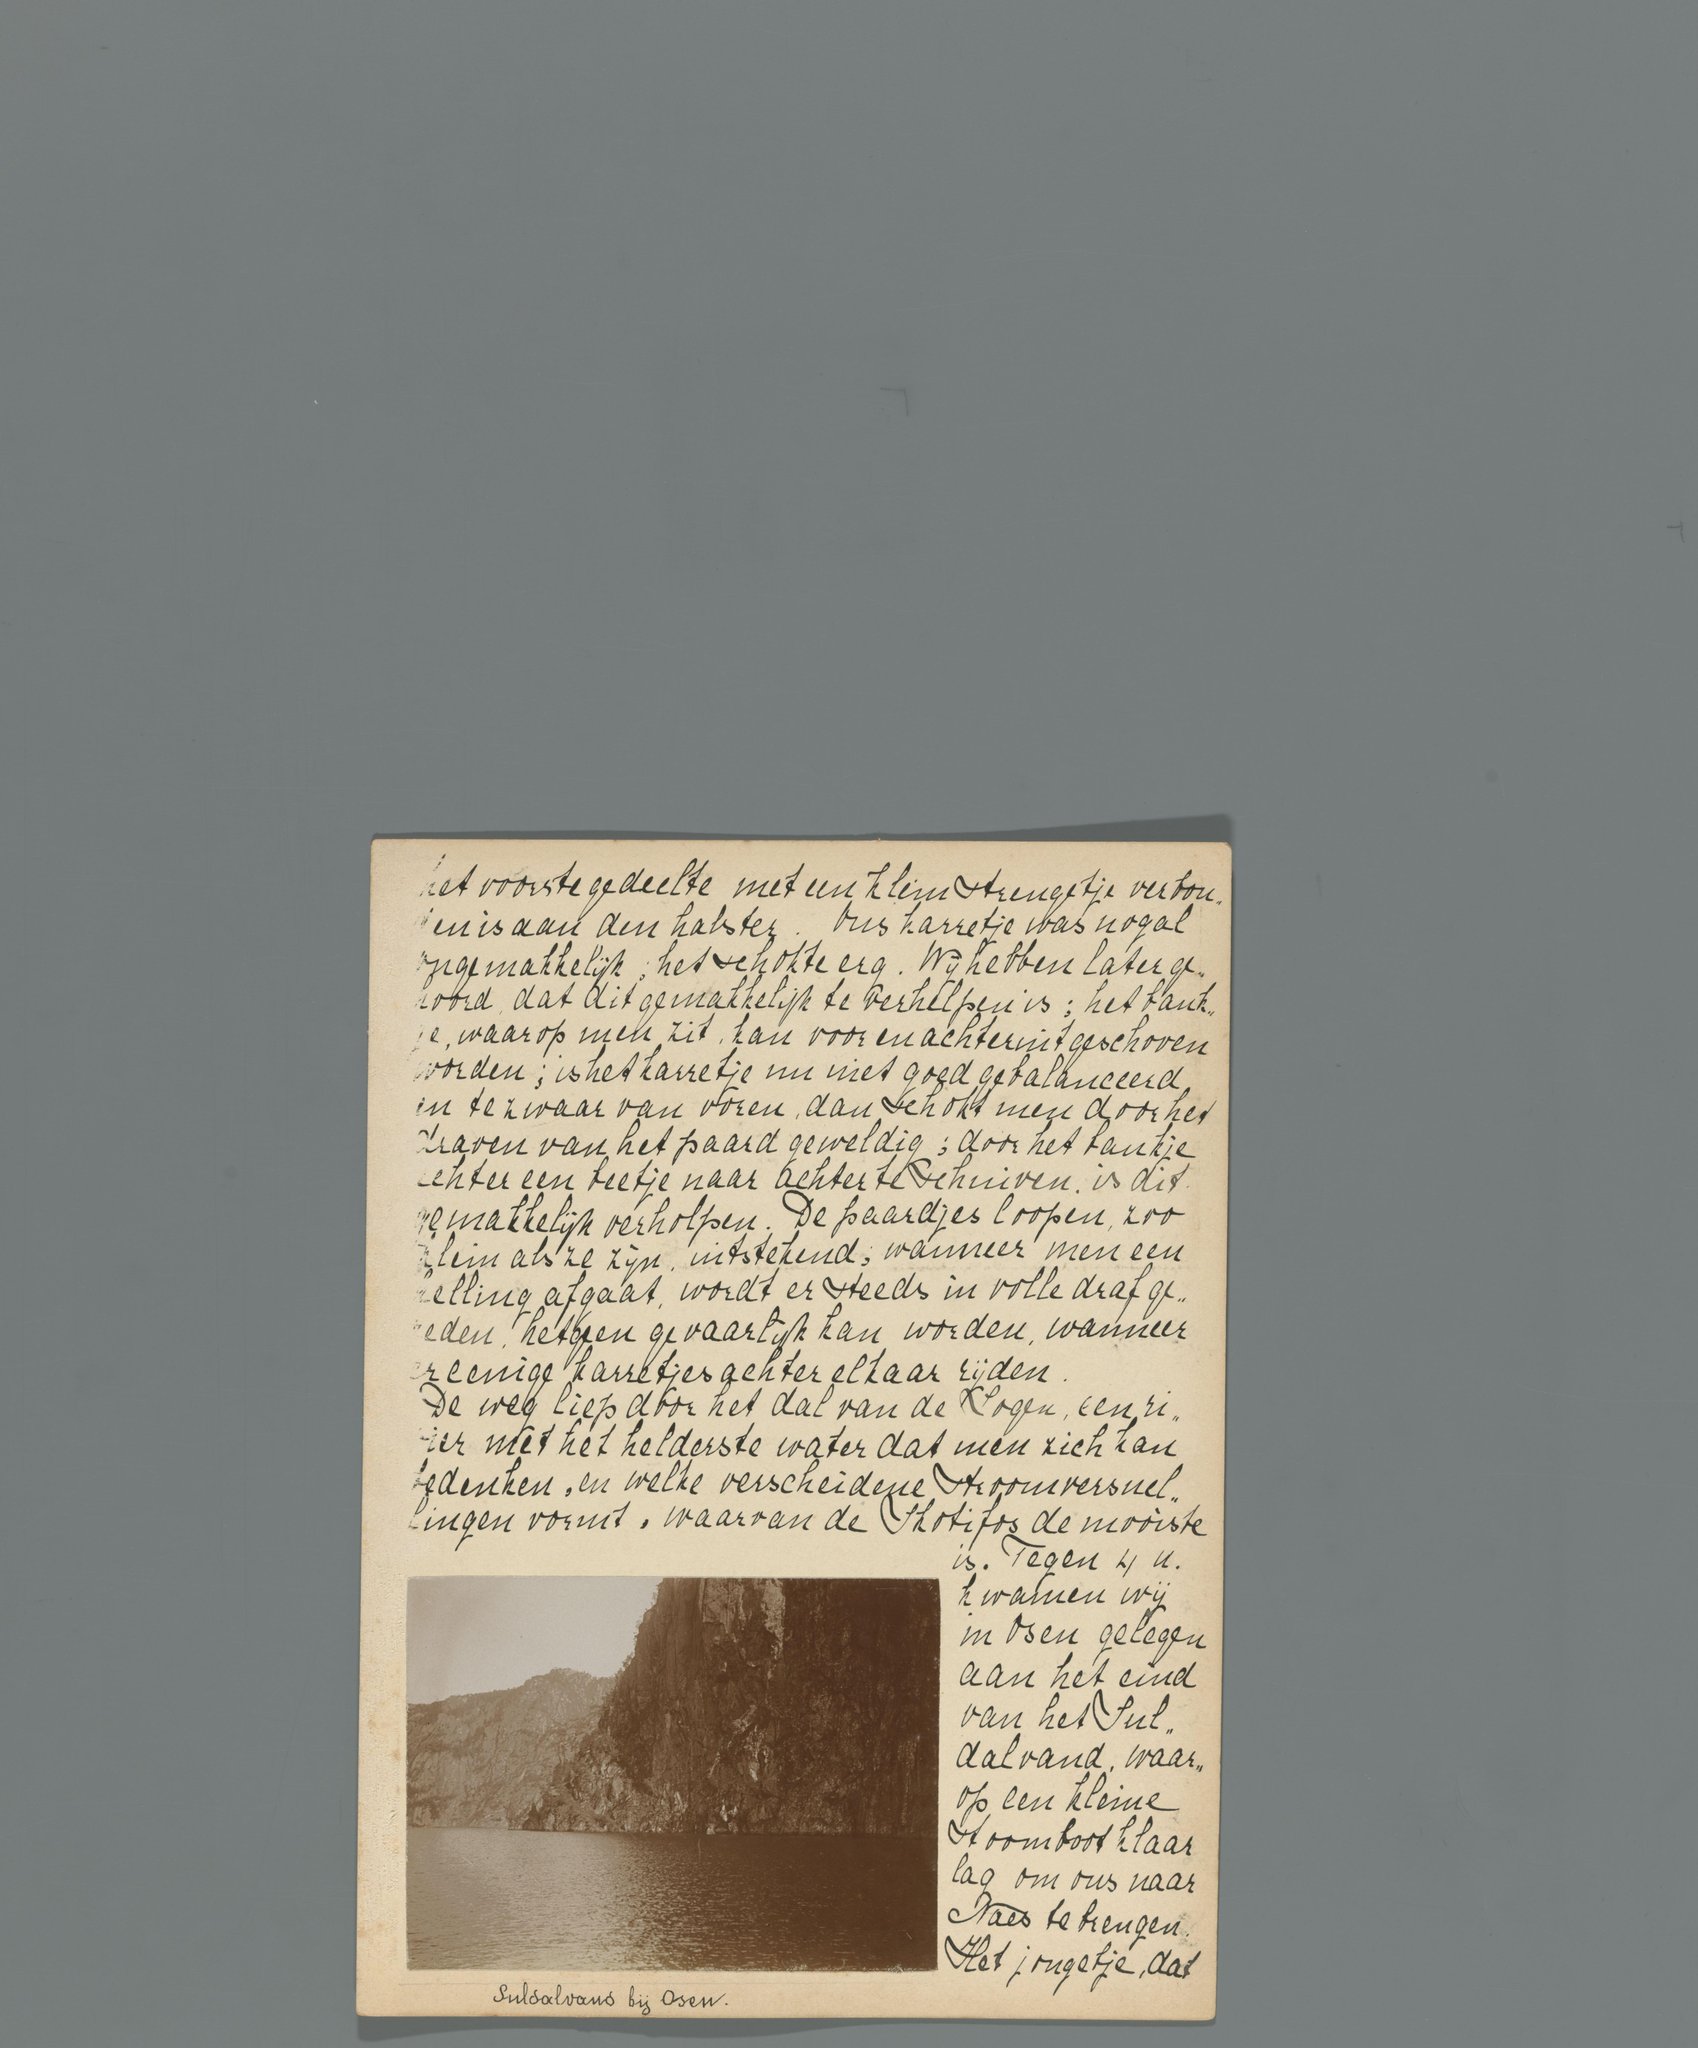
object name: page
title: Elfde pagina van een dagboek van een reis door Noorwegen met een foto met een gezicht op Suldal Vand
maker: hendrik herman van den berg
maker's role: amateurfotograaf, jurist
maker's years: 1875-1944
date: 1895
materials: paper, ink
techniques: pen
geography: suldal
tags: batavia, amsterdam, hendrik herman van den berg, gulf, bay, handwriting, written text, 'en route', traveller under way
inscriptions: caption: ‘Suldalvand bij Osen.’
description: Tiende pagina van een dagboek met het verslag van een reis door Noorwegen gemaakt door Hendrik Herman van den Berg en zijn neef Guillaume Louis Jacques Holle tussen 5 en 20 juli 1895. Op het dagboekblad is een foto geplakt met een gezicht op Suldal Vand.